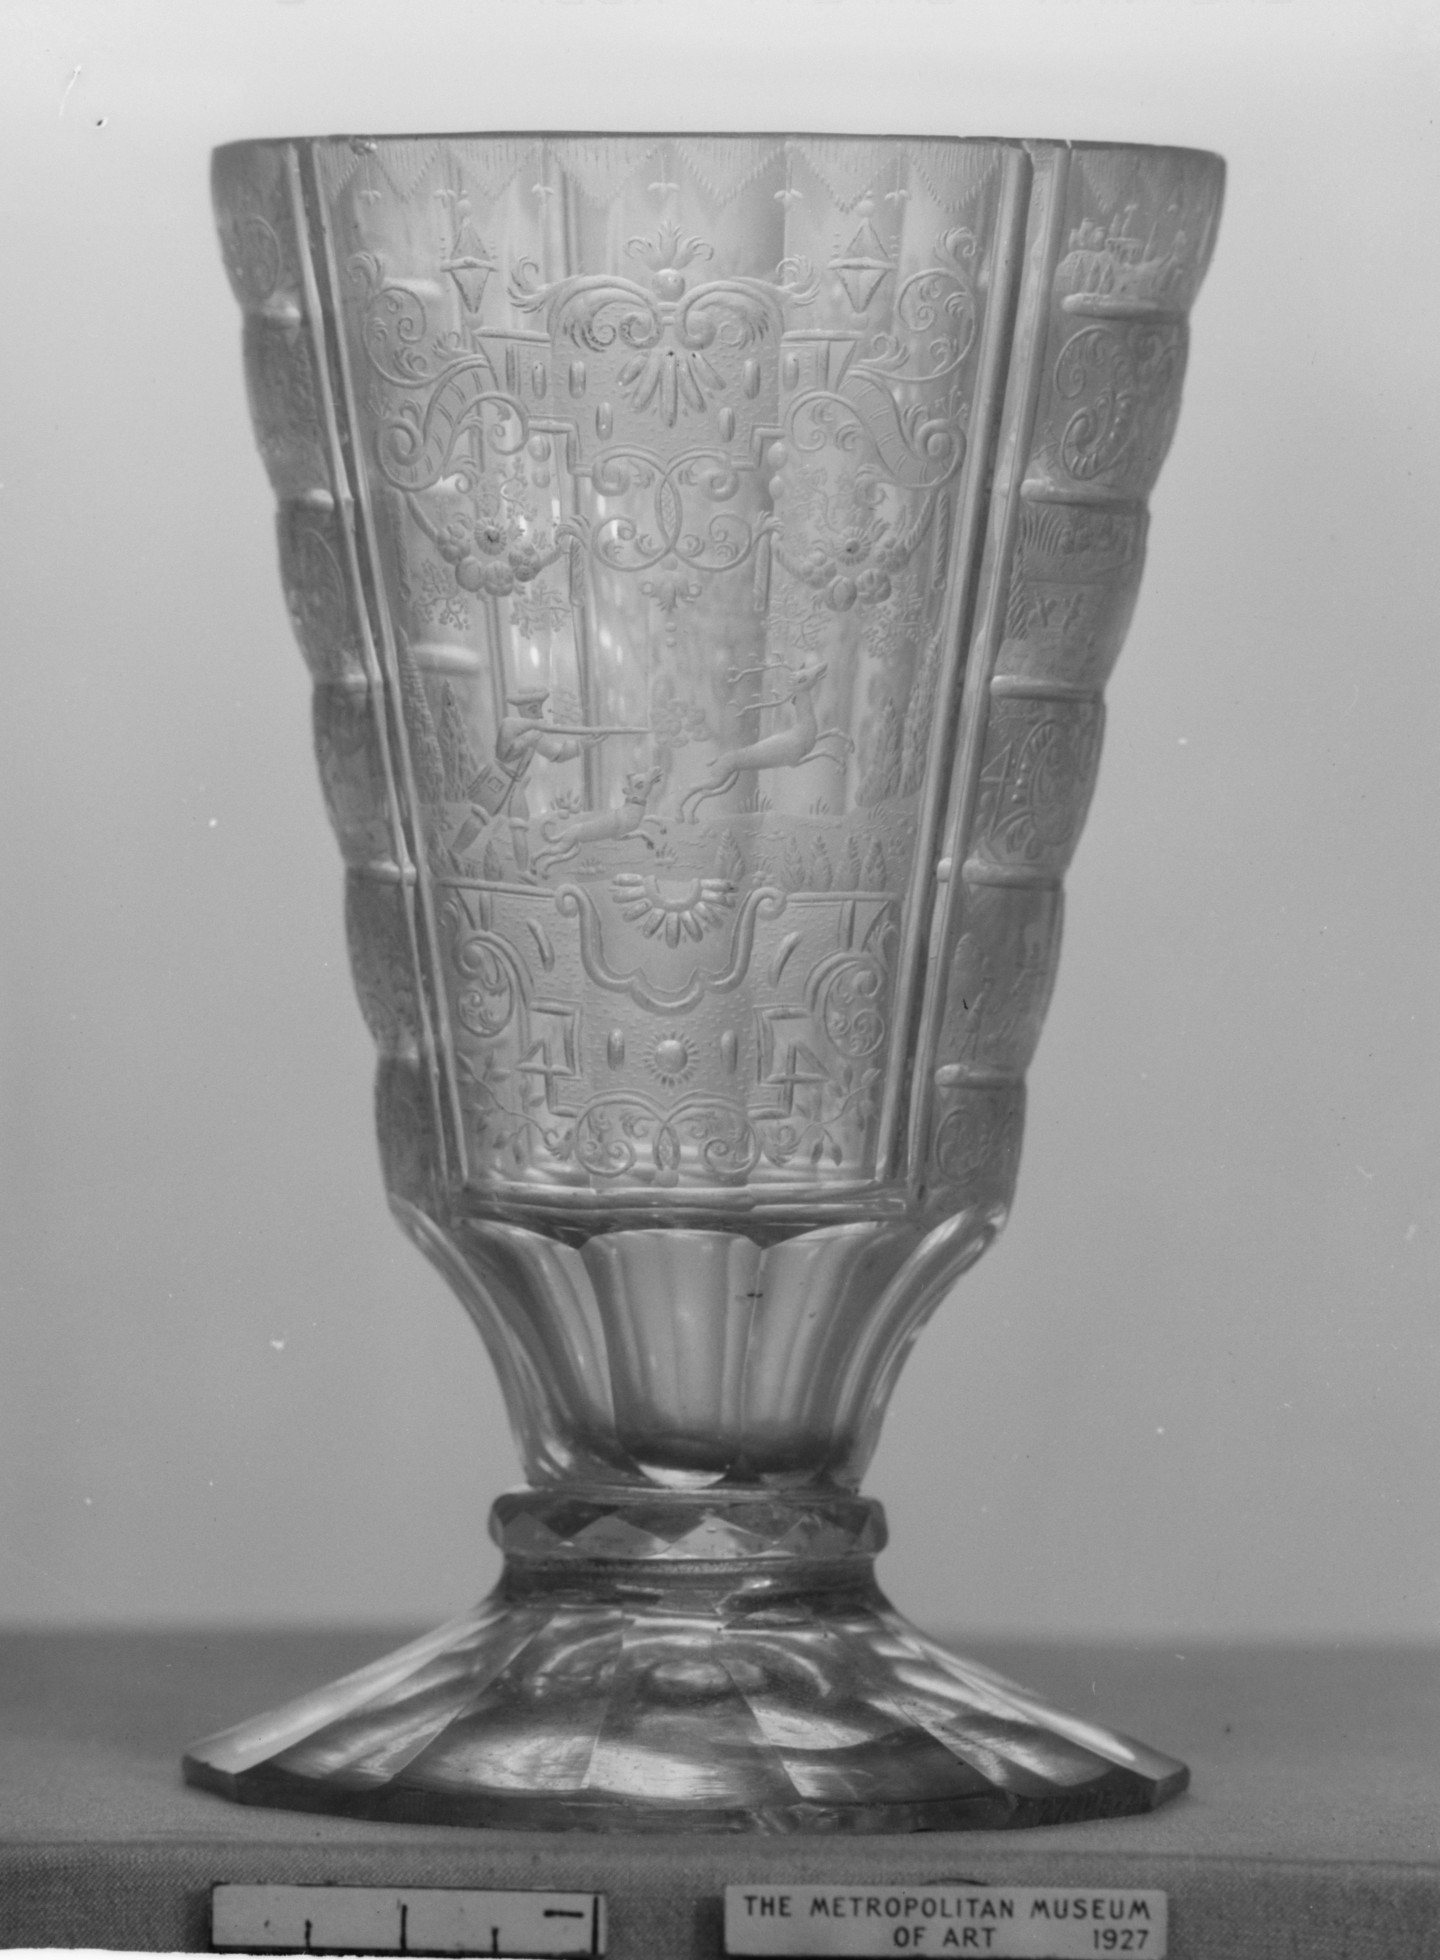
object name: beaker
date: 1730-1740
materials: glass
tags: hunting,deer,dogs